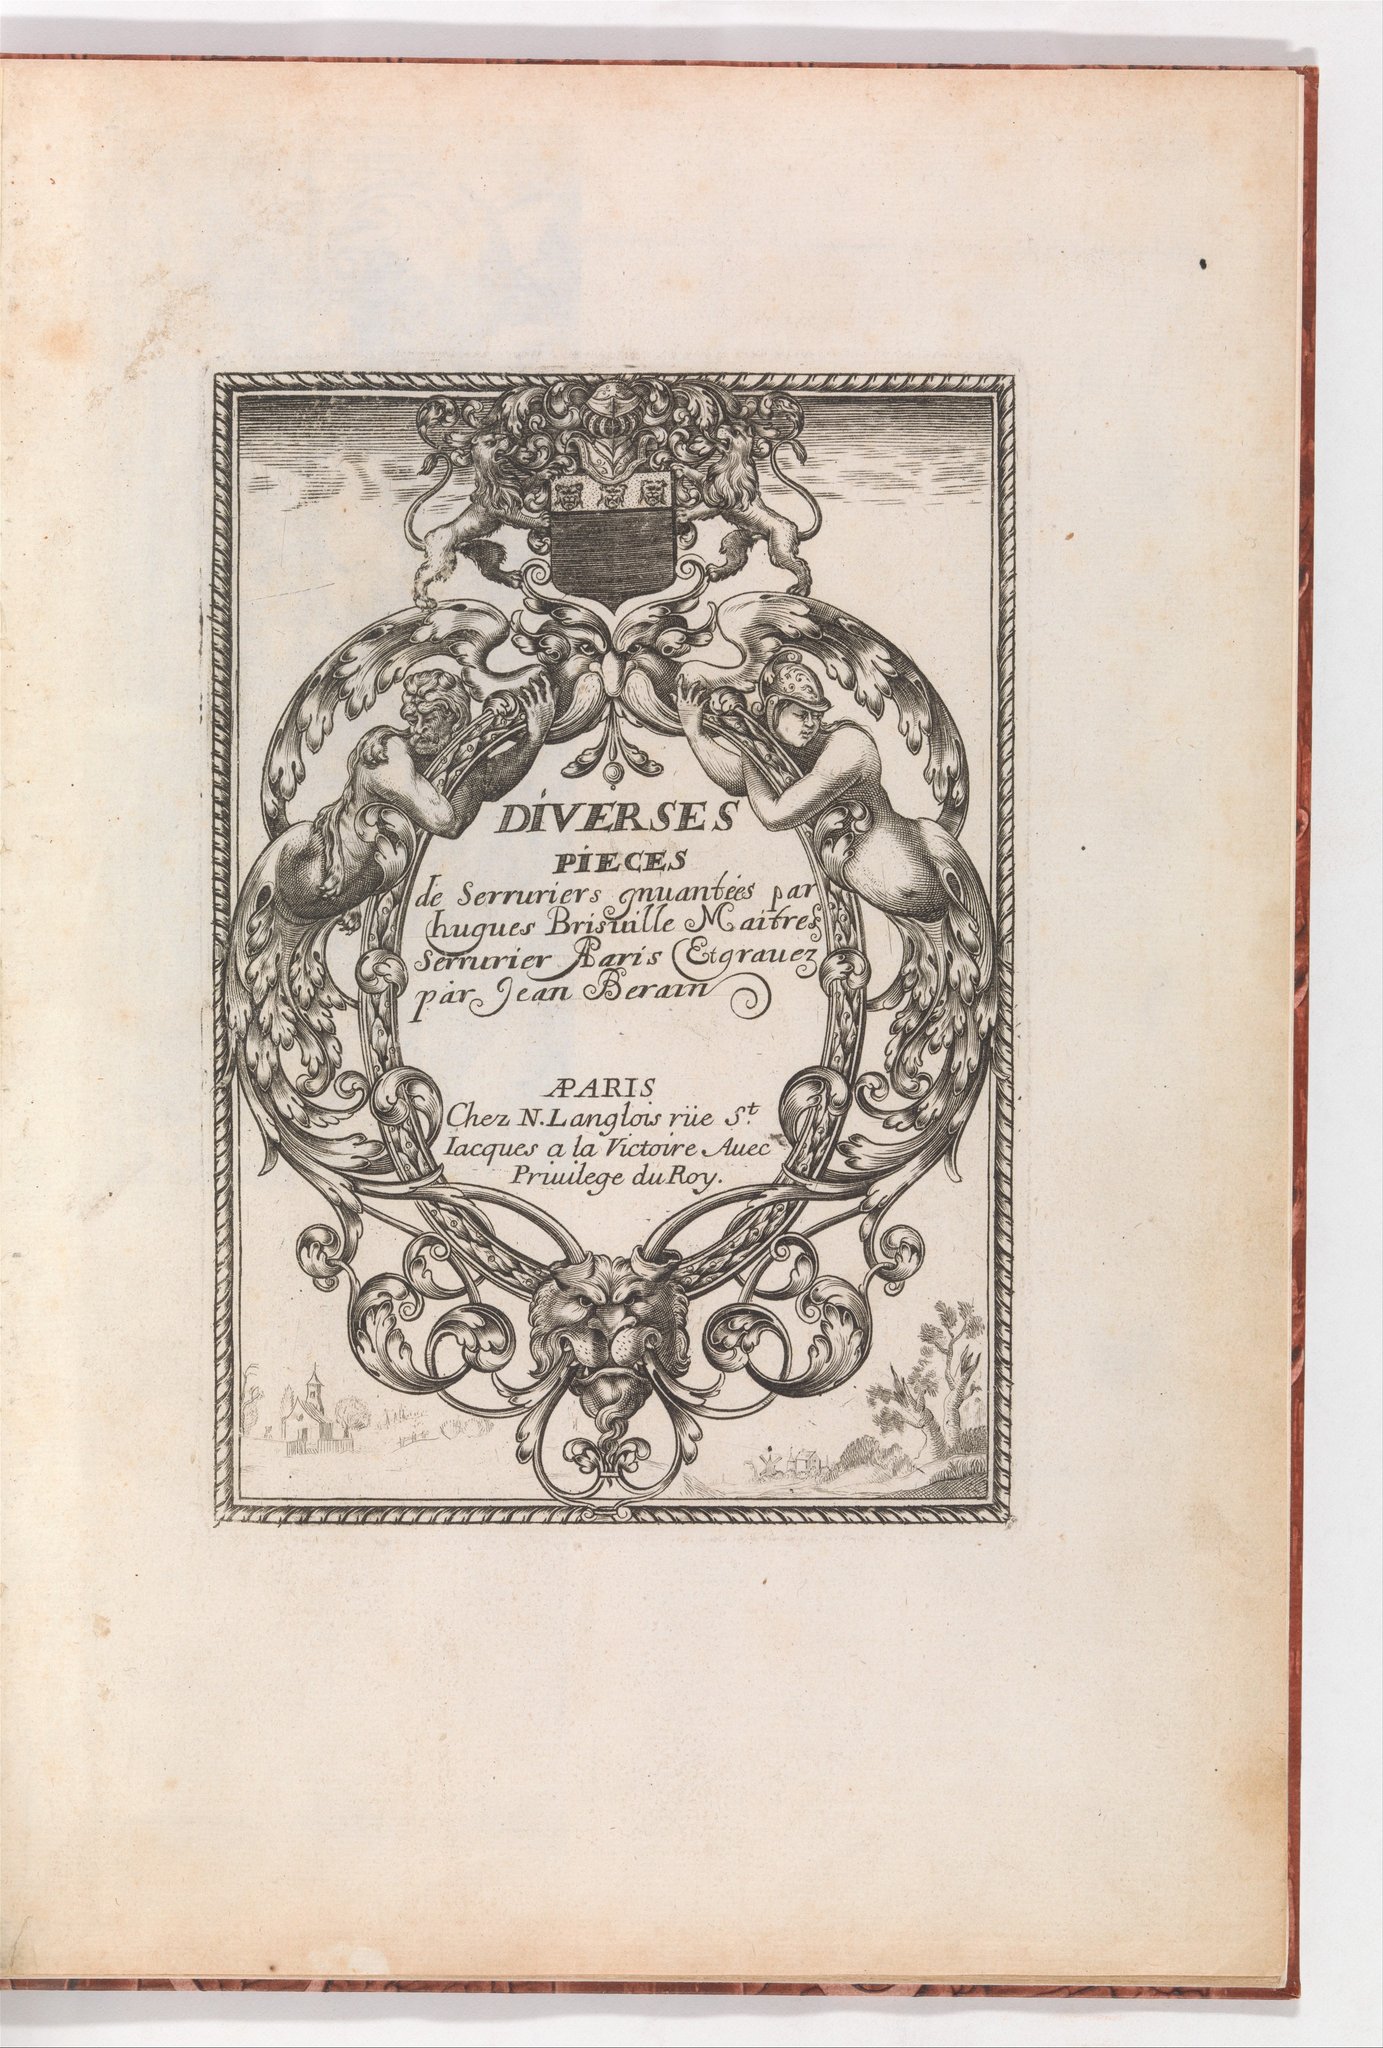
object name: album print ornament architecture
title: Diverses Pieces de Serruriers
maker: jean berain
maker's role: artist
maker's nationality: french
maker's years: 1640-1711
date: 1663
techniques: engraving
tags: lions,coat of arms